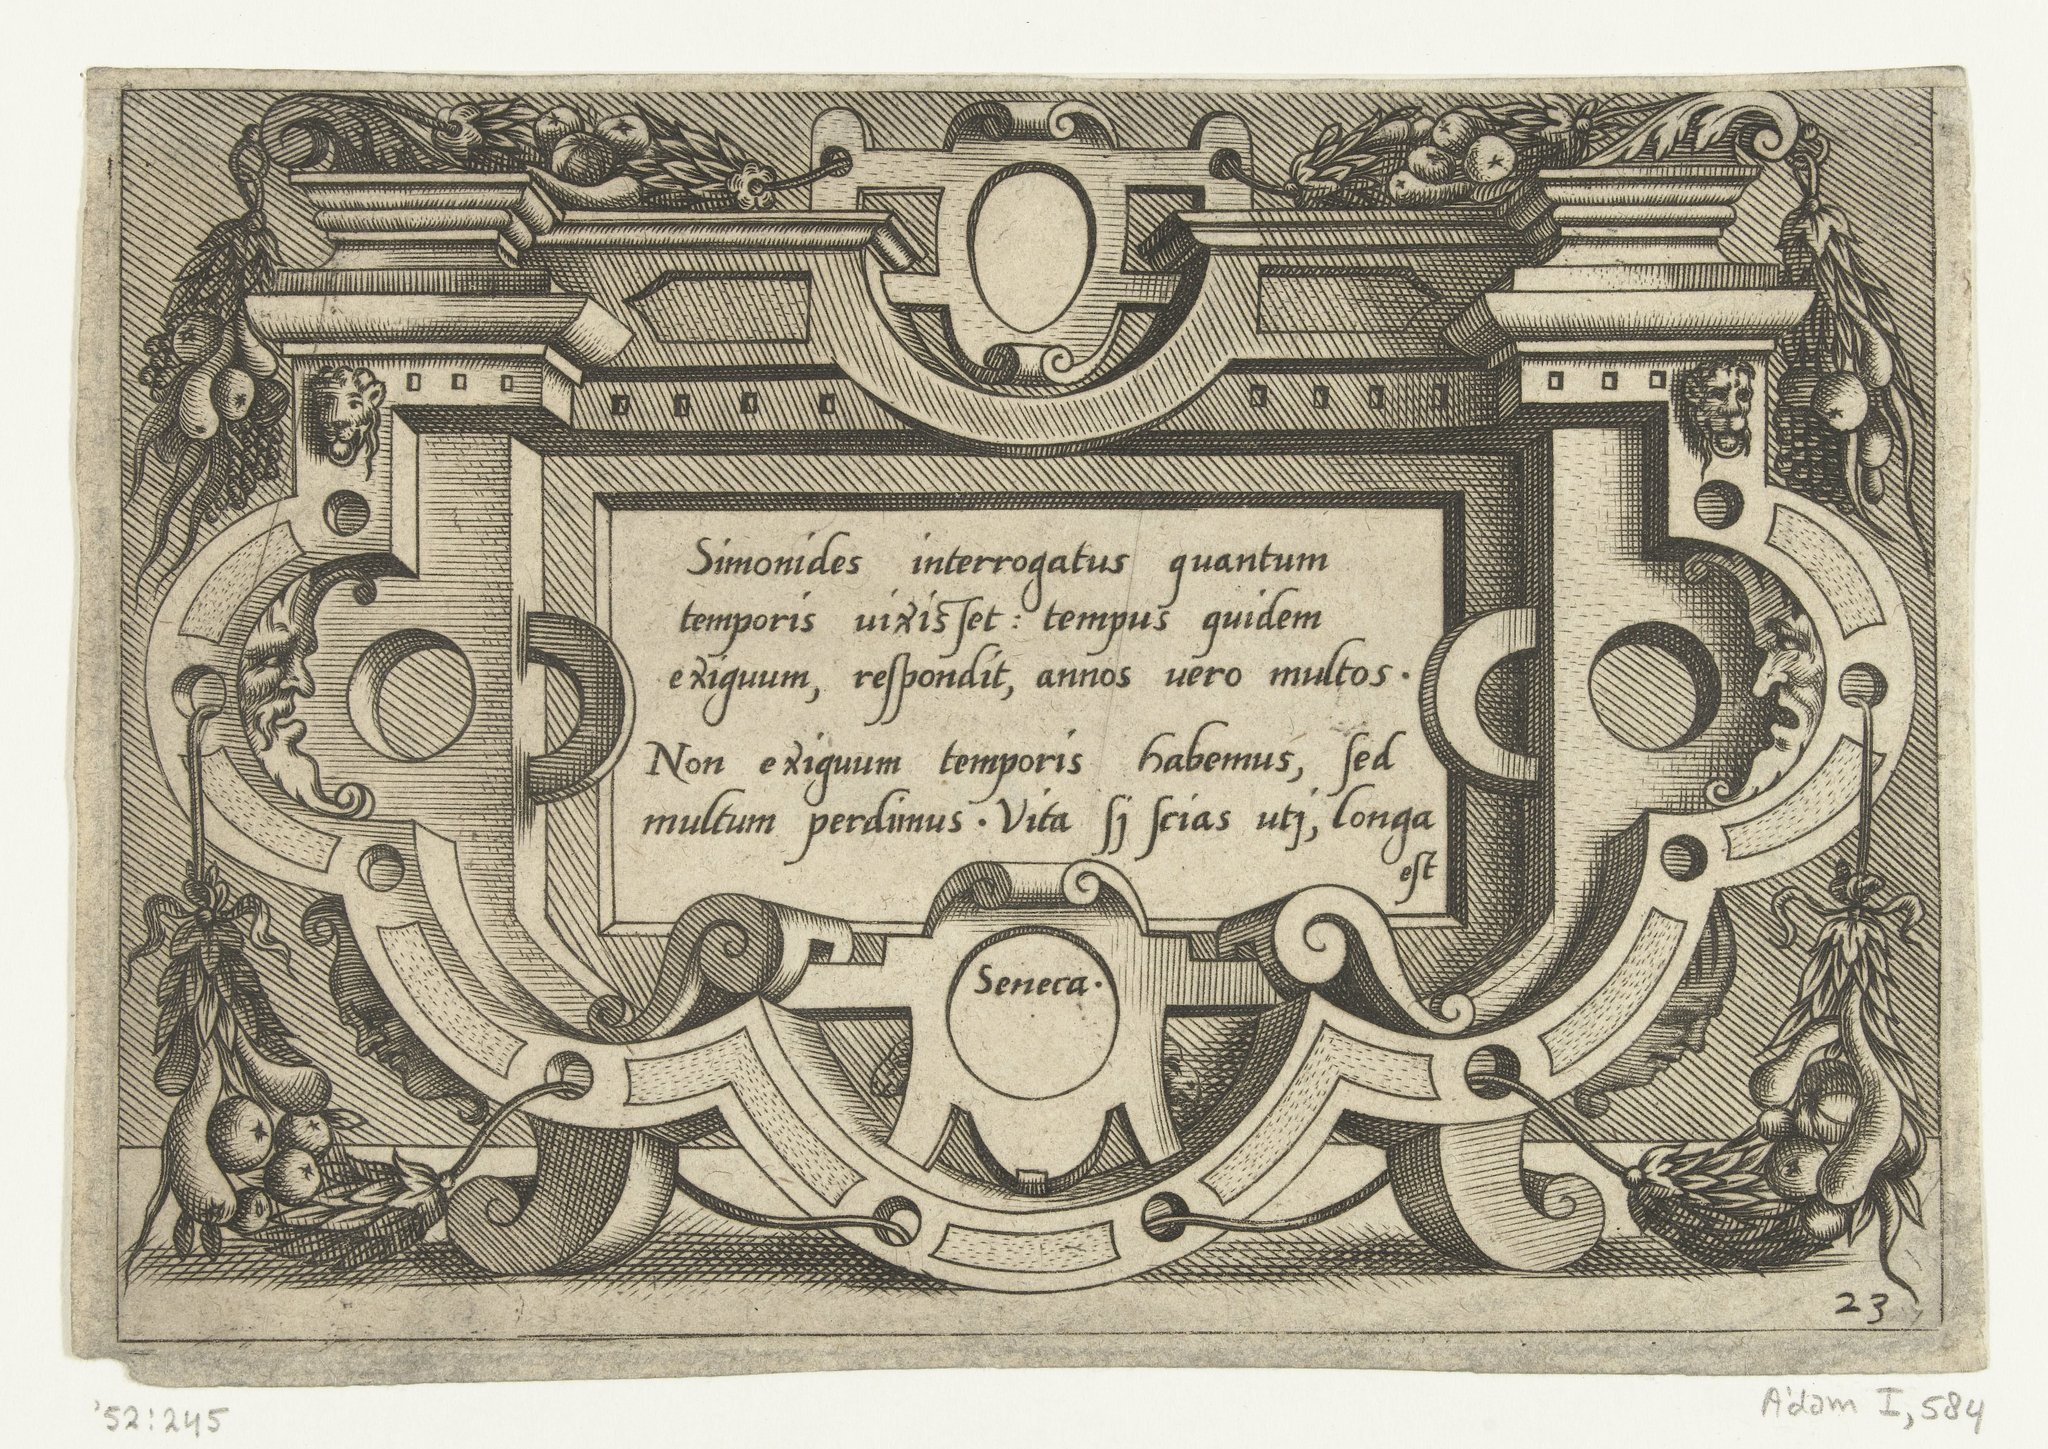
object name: ornament print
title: Cartouche met een citaat van Seneca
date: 1553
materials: paper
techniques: engraving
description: Het citaat staat in een omlijsting van rolwerk met guirlandes en mascarons.